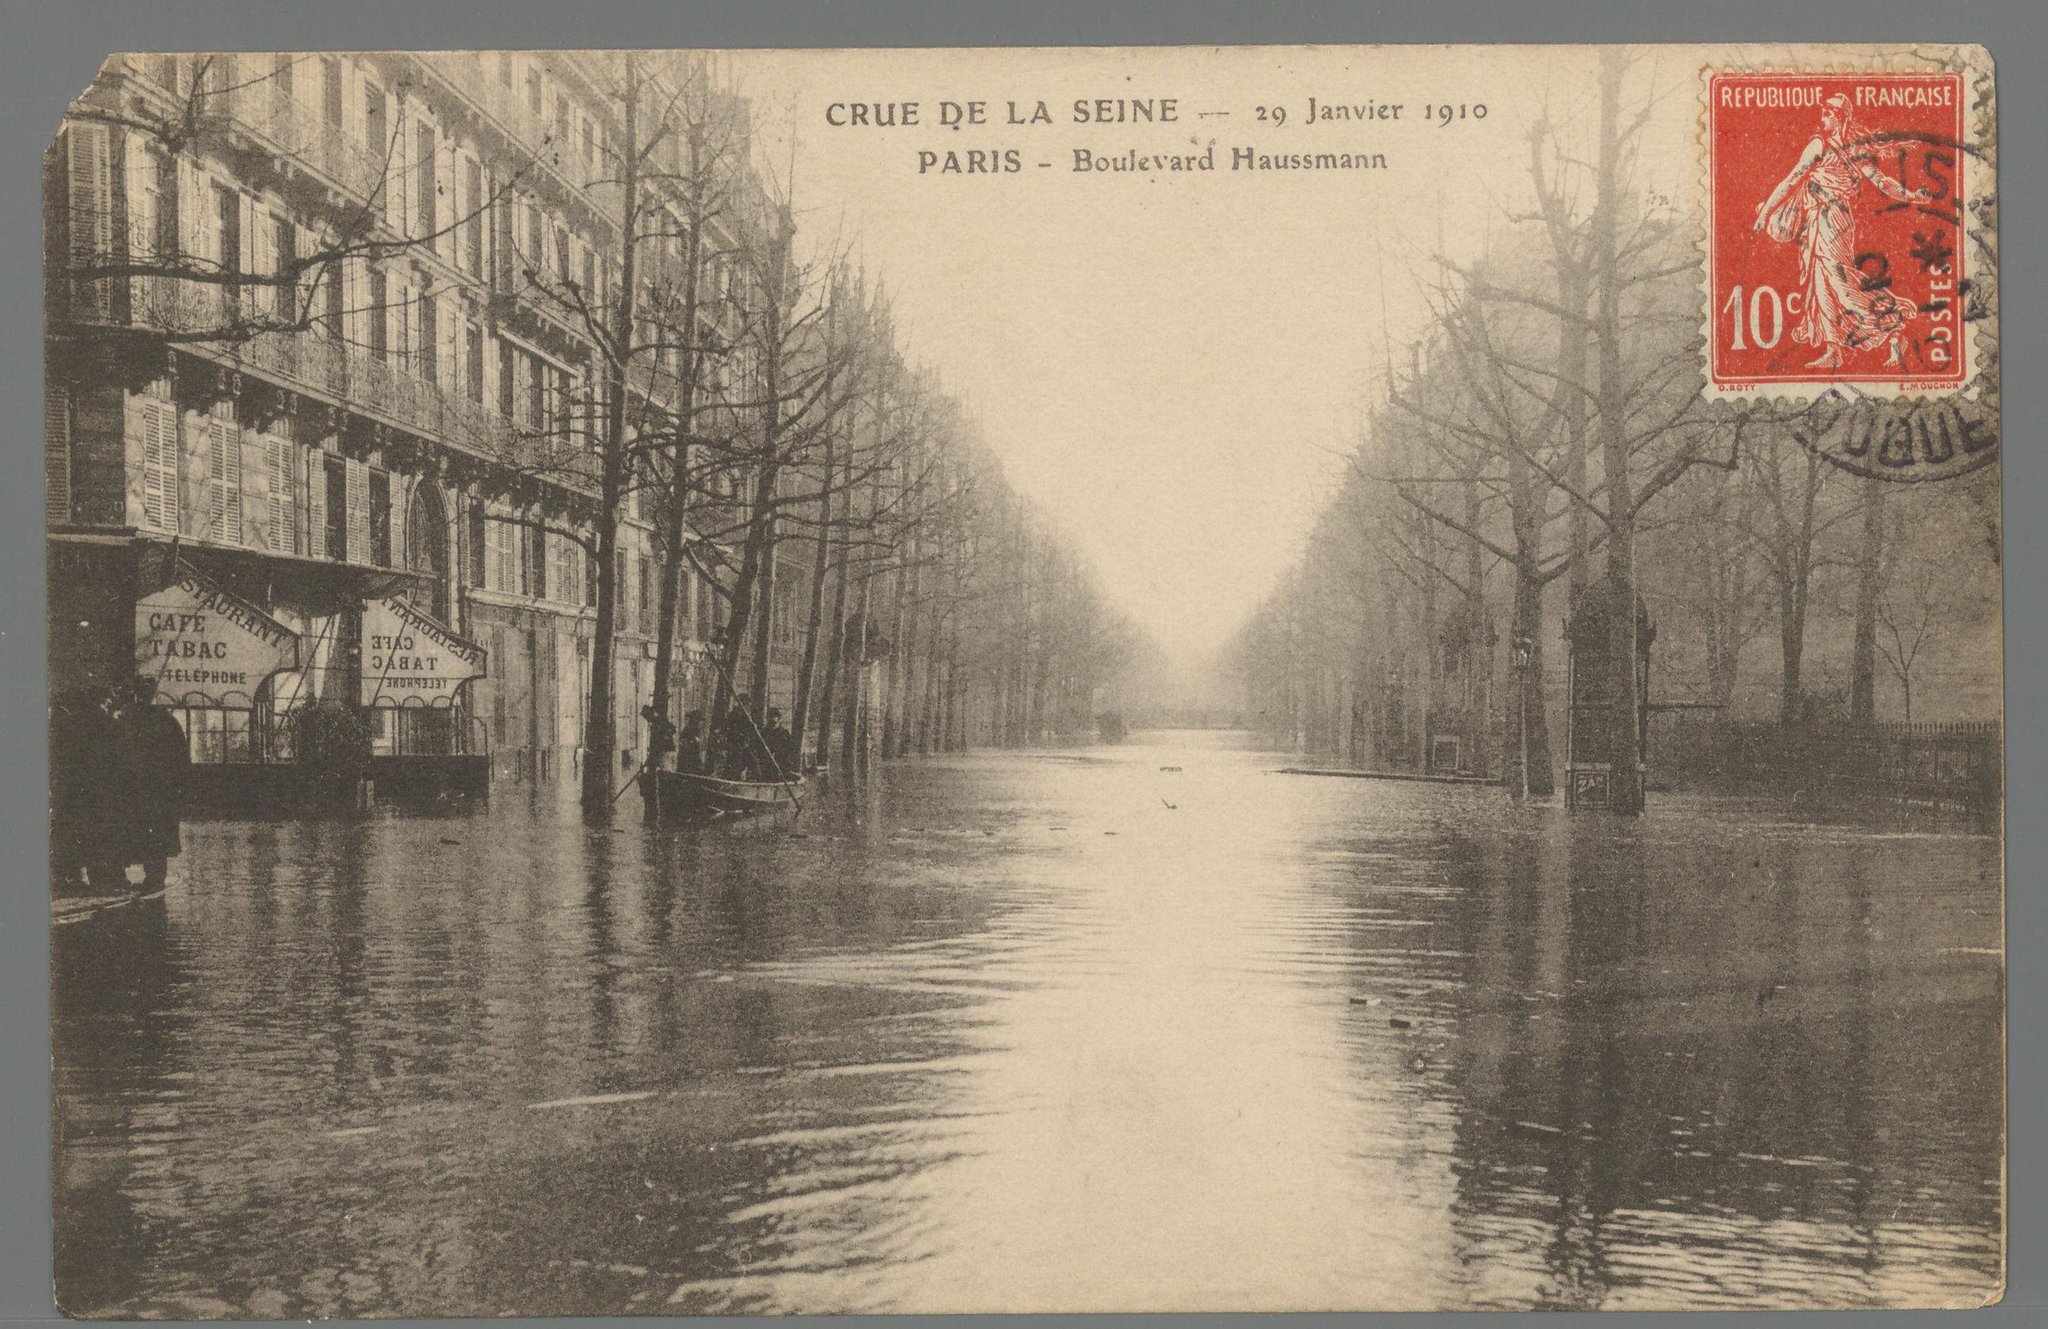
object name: photomechanical print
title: Paris. Boulevard Haussmann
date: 1910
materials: cardboard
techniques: photograph, writing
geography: paris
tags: flood, avenue, boulevard, promenade, esplanade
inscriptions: postage stamp